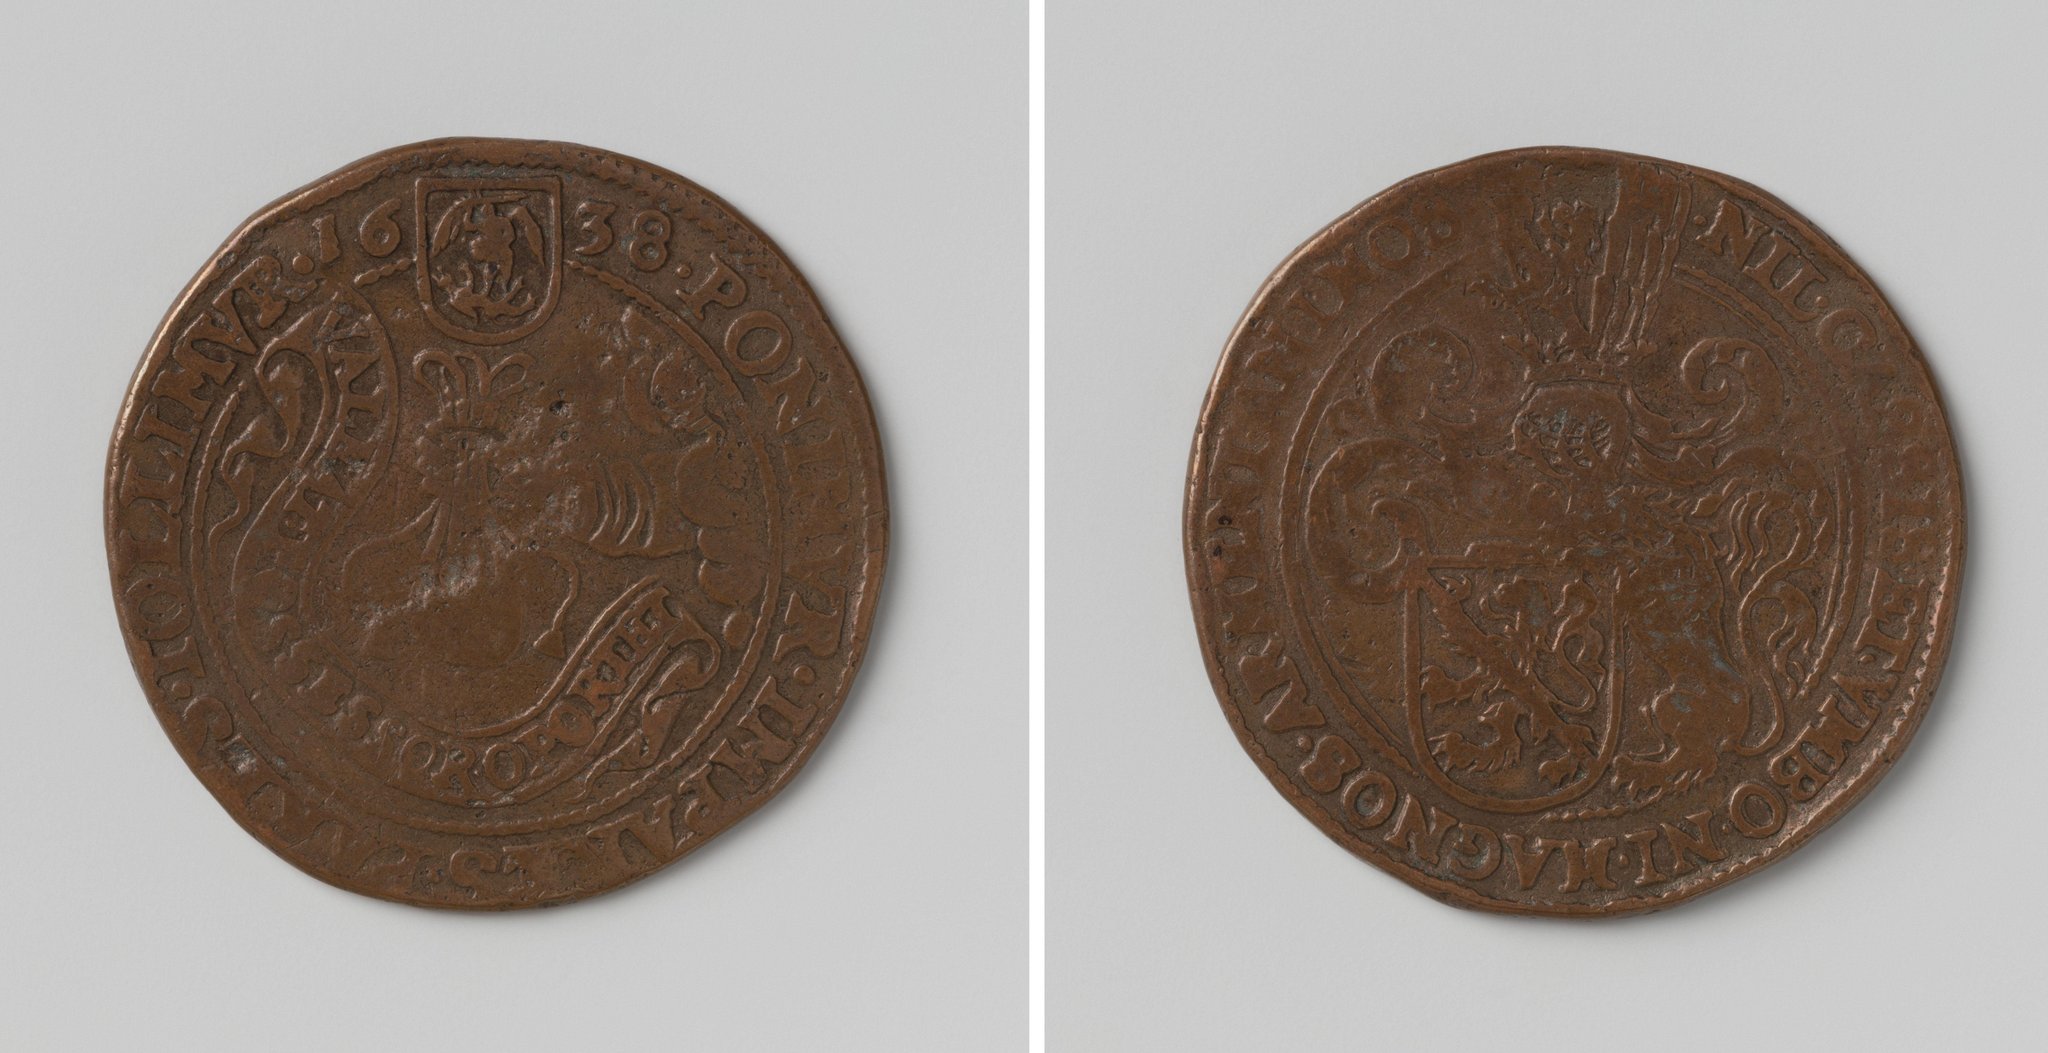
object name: jeton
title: Onverstoorbaarheid der zuidelijke Nederlanden, ondanks het tegen haar gerichte verbond tussen Frankrijk en de Republiek, rekenpenning ter ere van Jerome Du Quesnoy, magistraat van de schatkist van Bru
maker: Anonymous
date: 1601-1637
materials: copper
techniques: striking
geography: brussels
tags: brussels, landvoogd der zuidelijke nederlanden ferdinand van oostenrijk